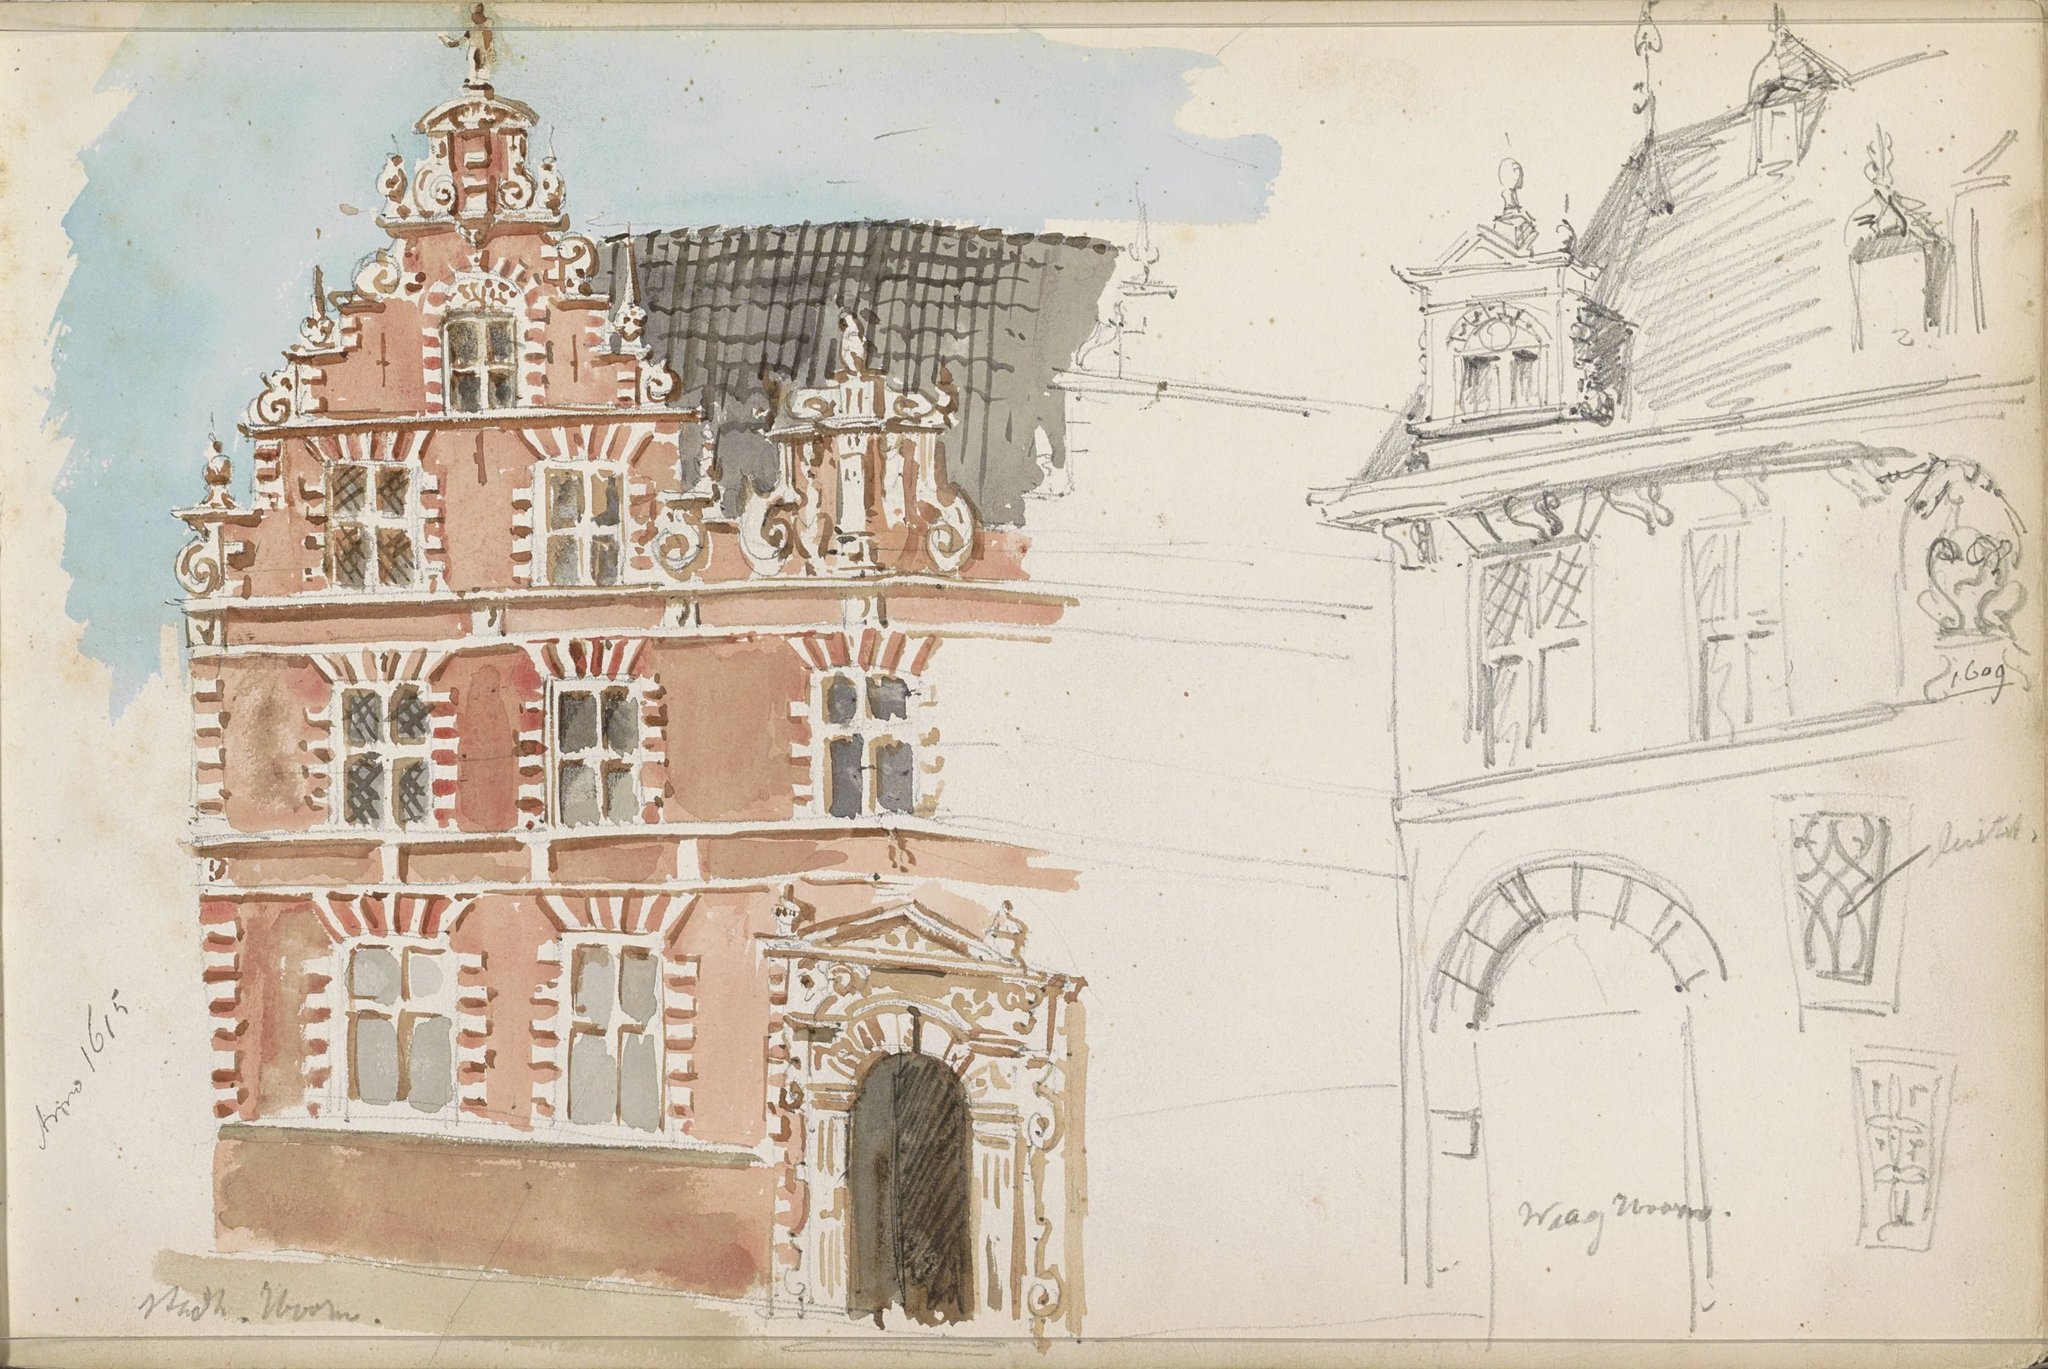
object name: sketchbook leaf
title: Stadhuis en de Waag te Hoorn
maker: isaac gosschalk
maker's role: draughtsman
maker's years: 1838-1907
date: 1862-1867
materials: paper, pencil, watercolor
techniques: brush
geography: hoorn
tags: townhall, weigh-house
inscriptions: annotation: ‘Anno 1615/ stadh Hoorn/ Waag Hoorn’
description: Blad 38 recto uit een schetsboek met 58 bladen.